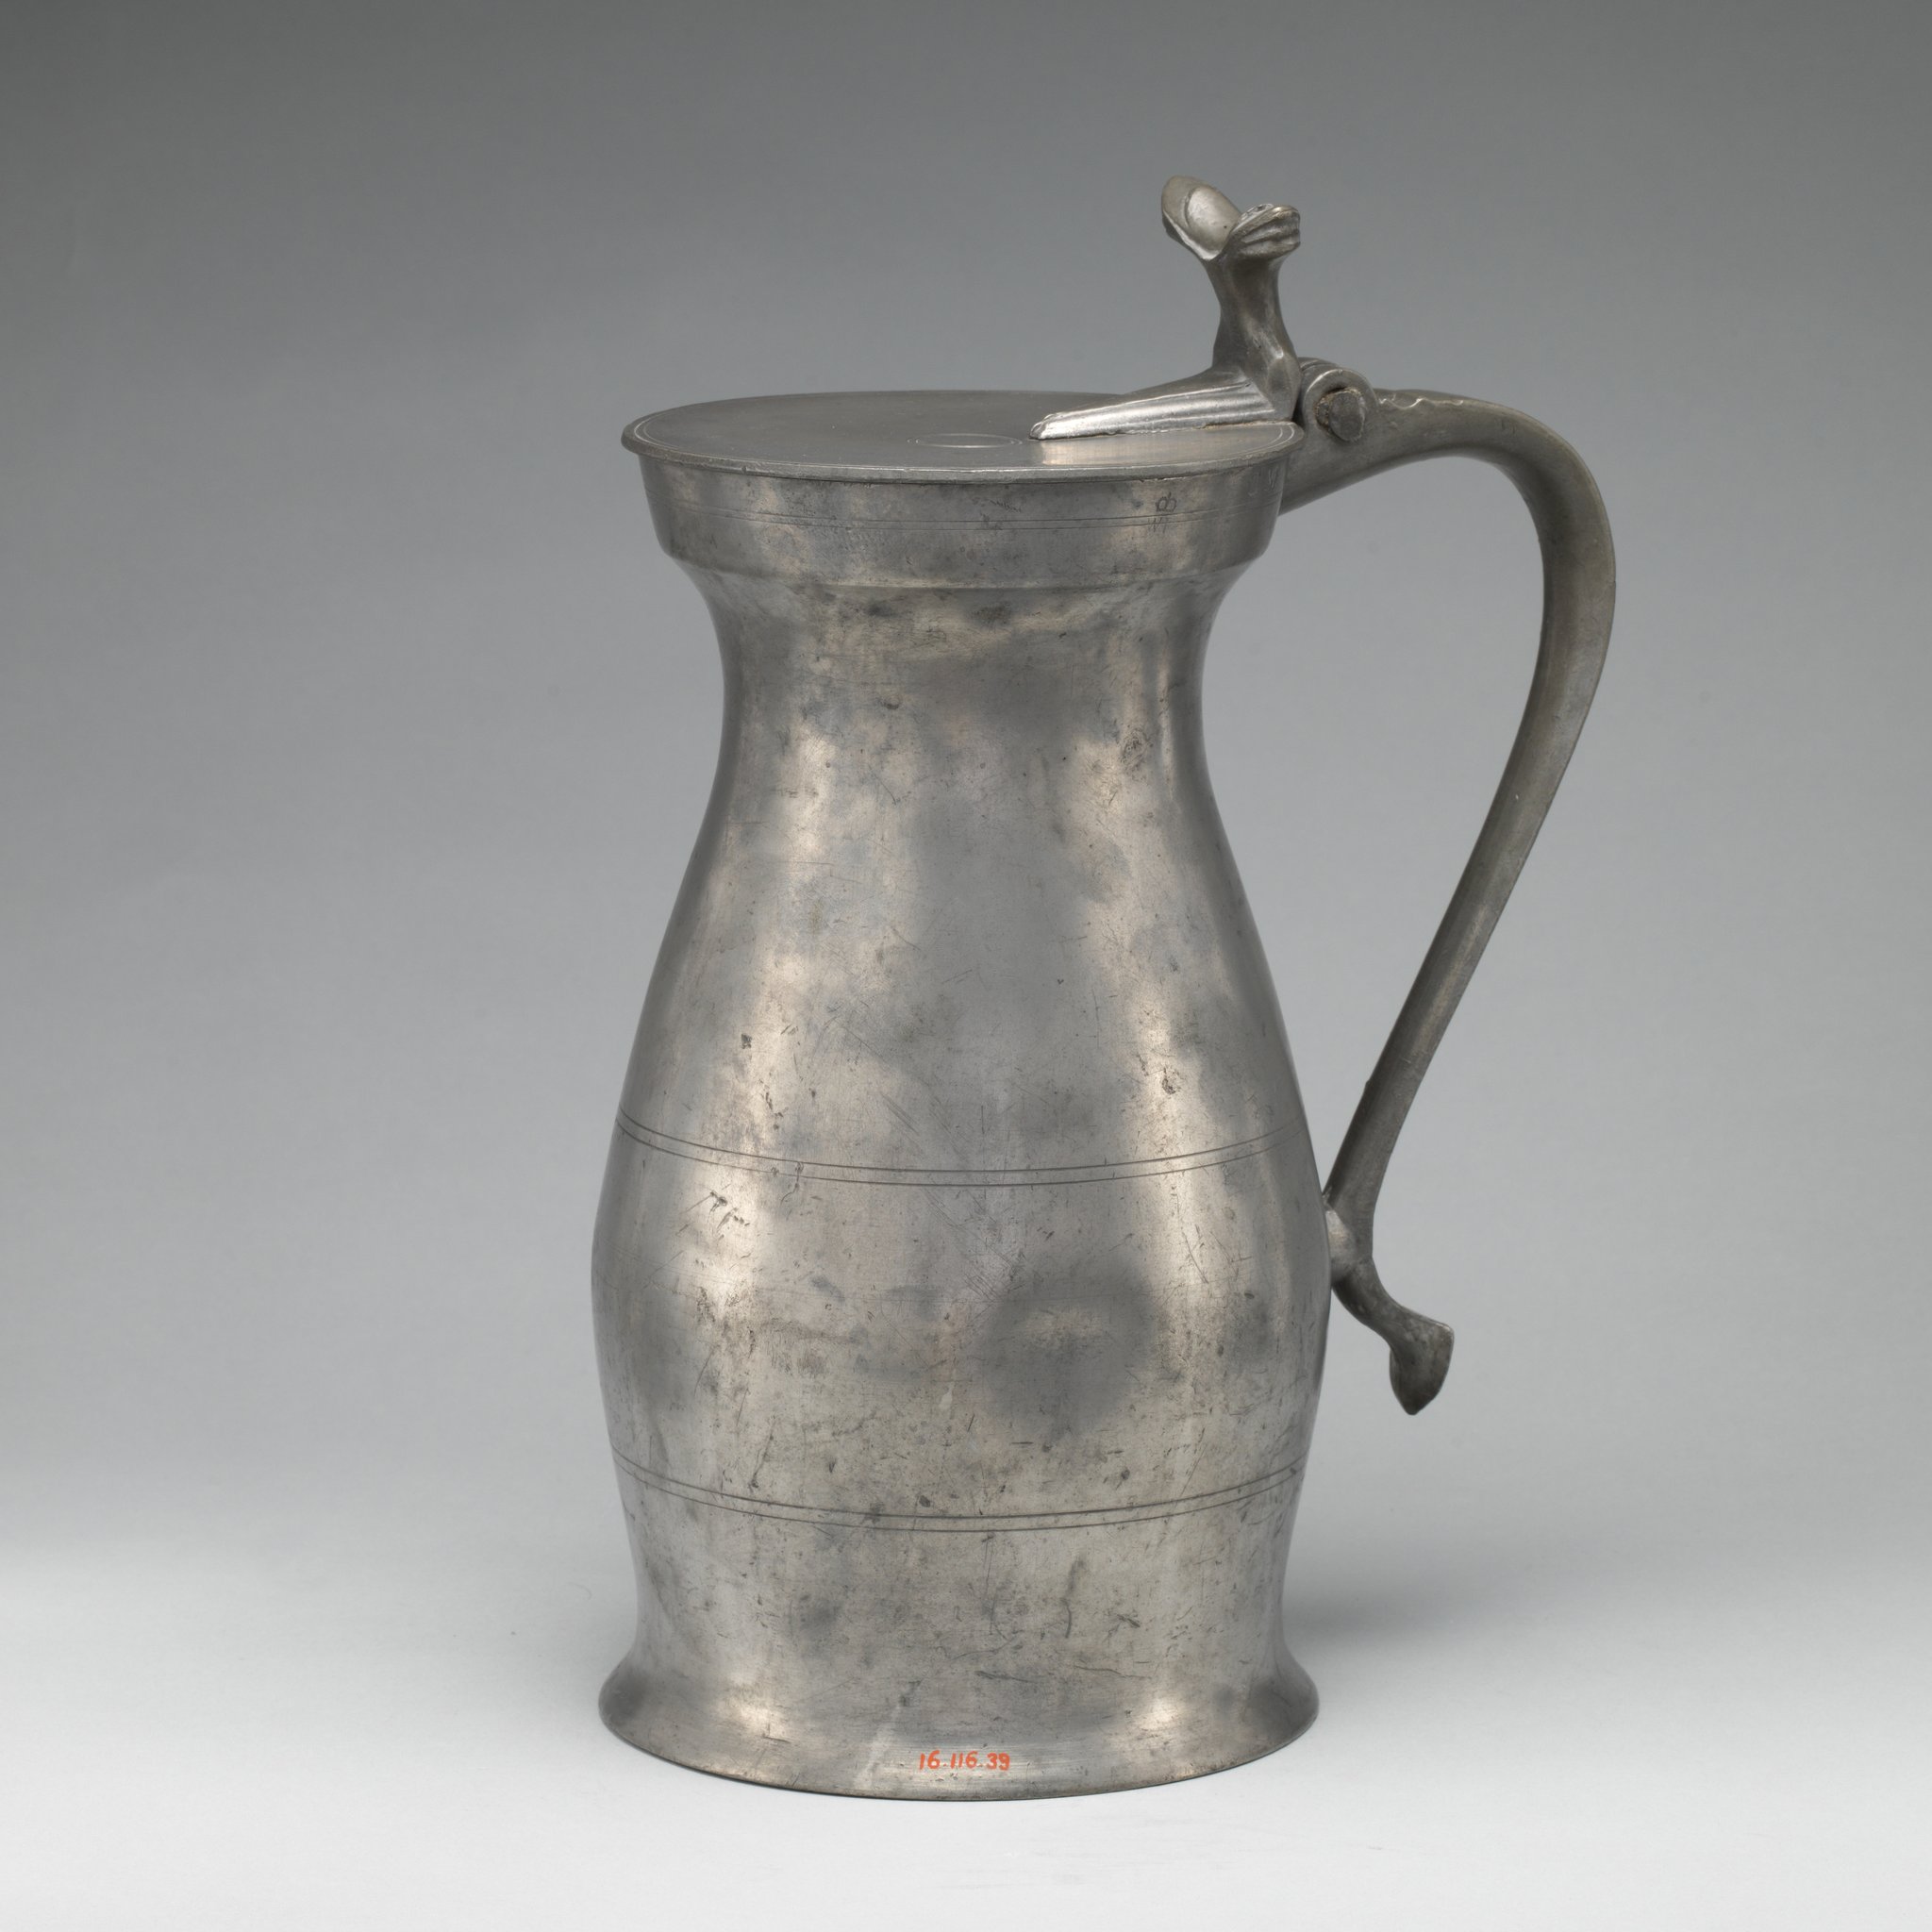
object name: measure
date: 1701-1800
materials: pewter